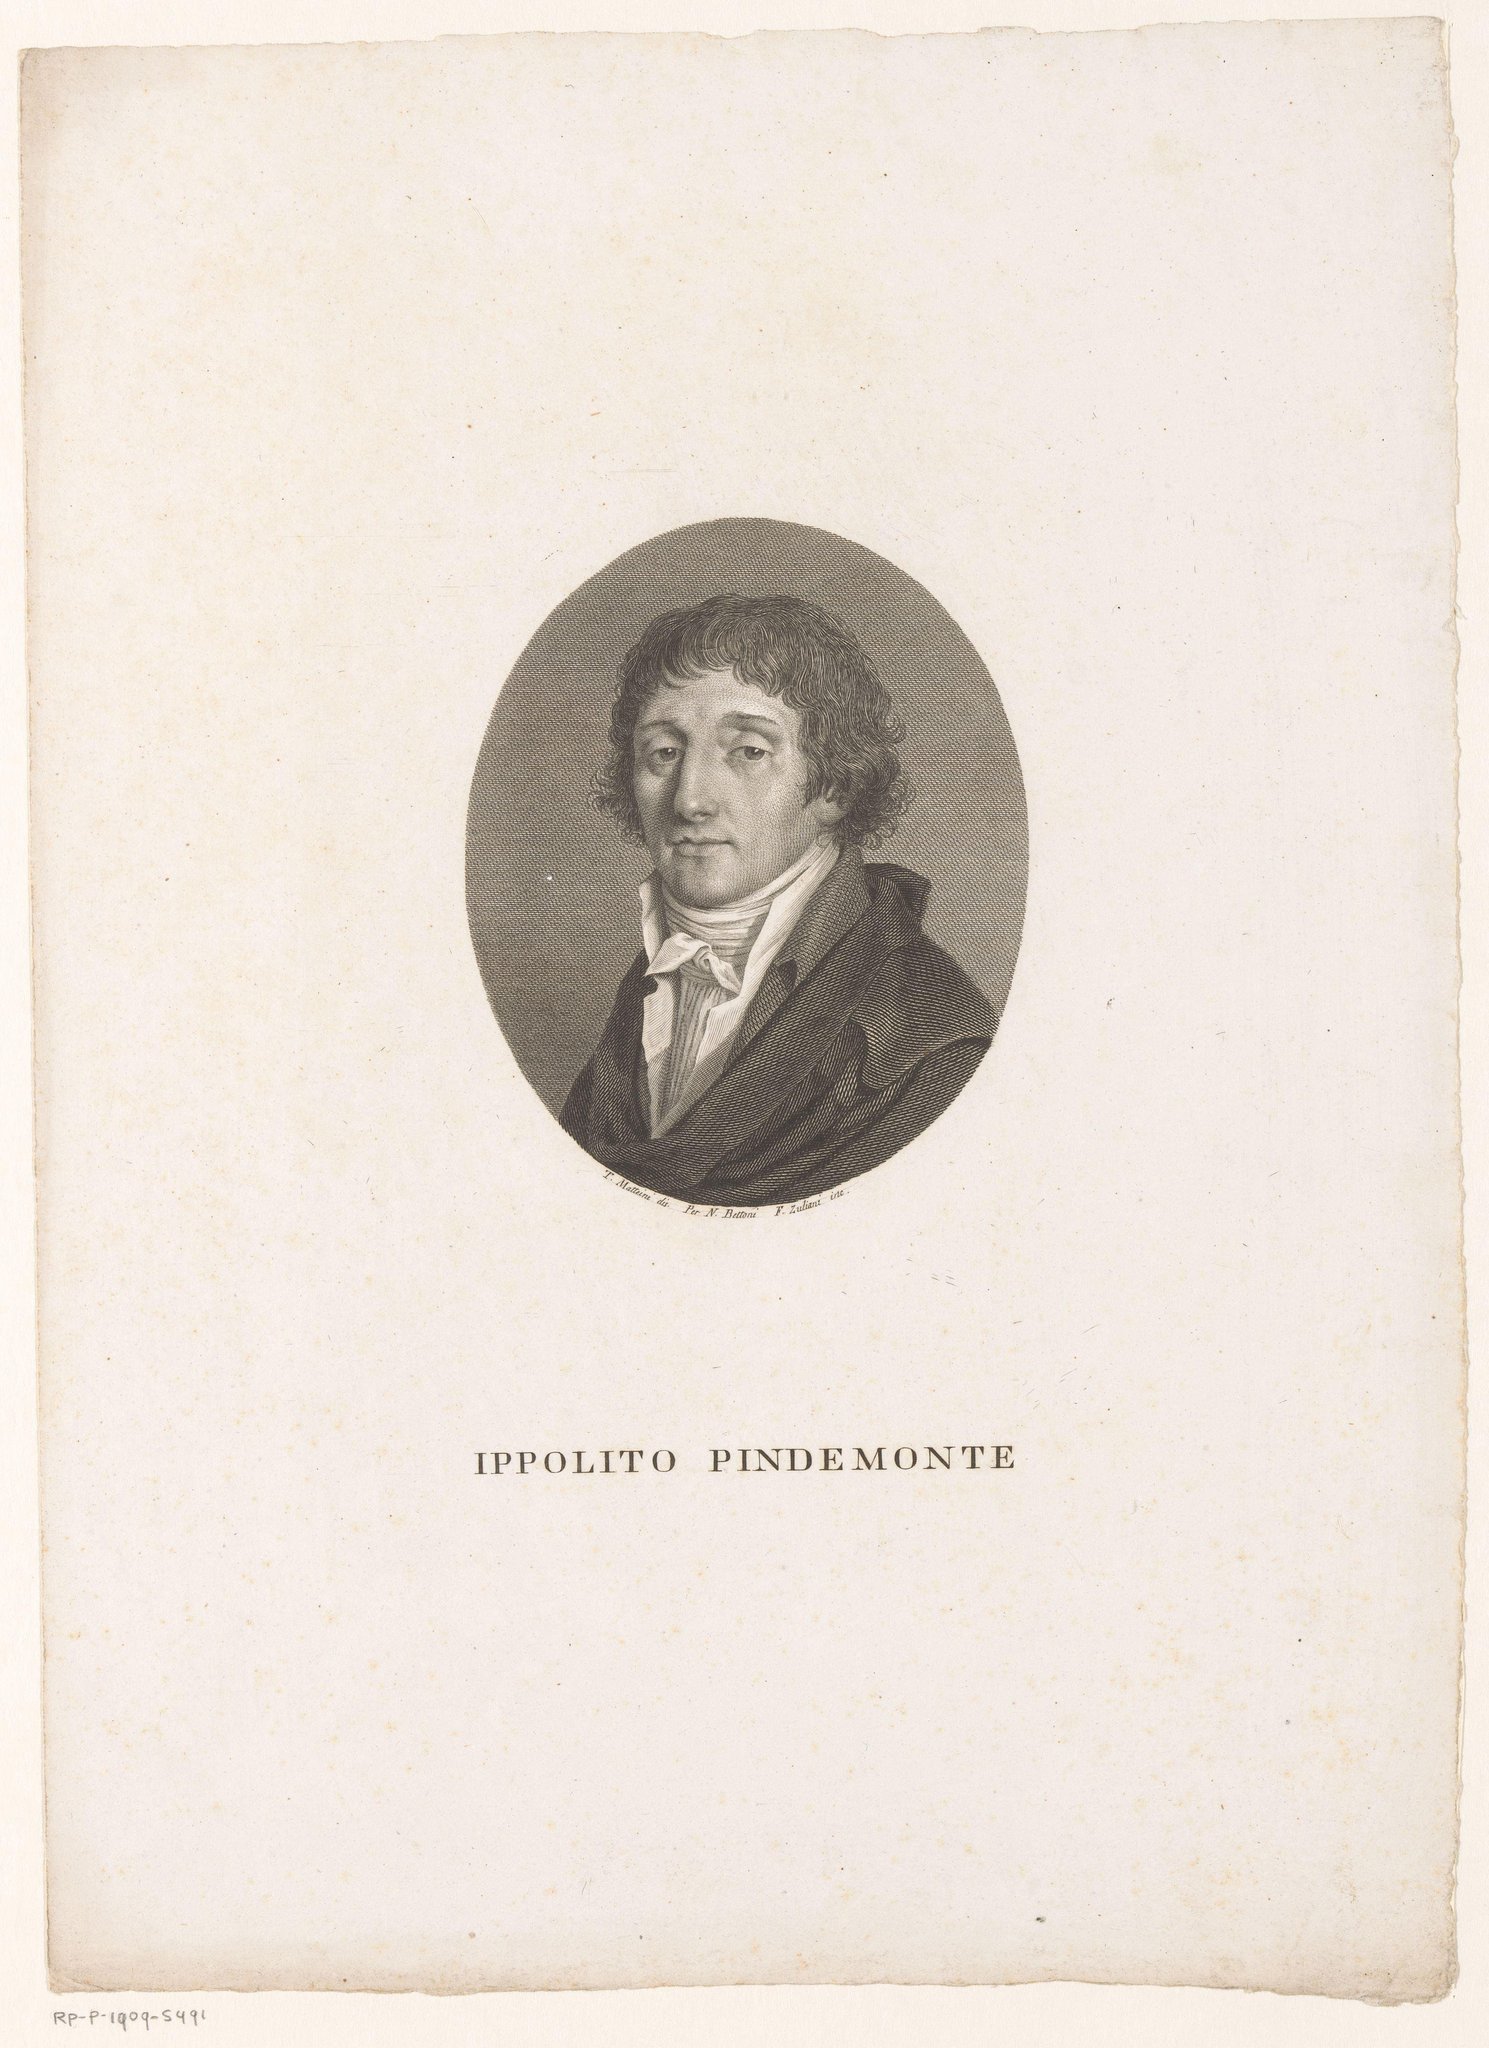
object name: print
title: Portret van dichter Ippolito Pindemonte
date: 1780-1834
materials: paper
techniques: engraving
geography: italy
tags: historical persons, writer, poet, author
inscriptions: collector's mark: Lugt 2228